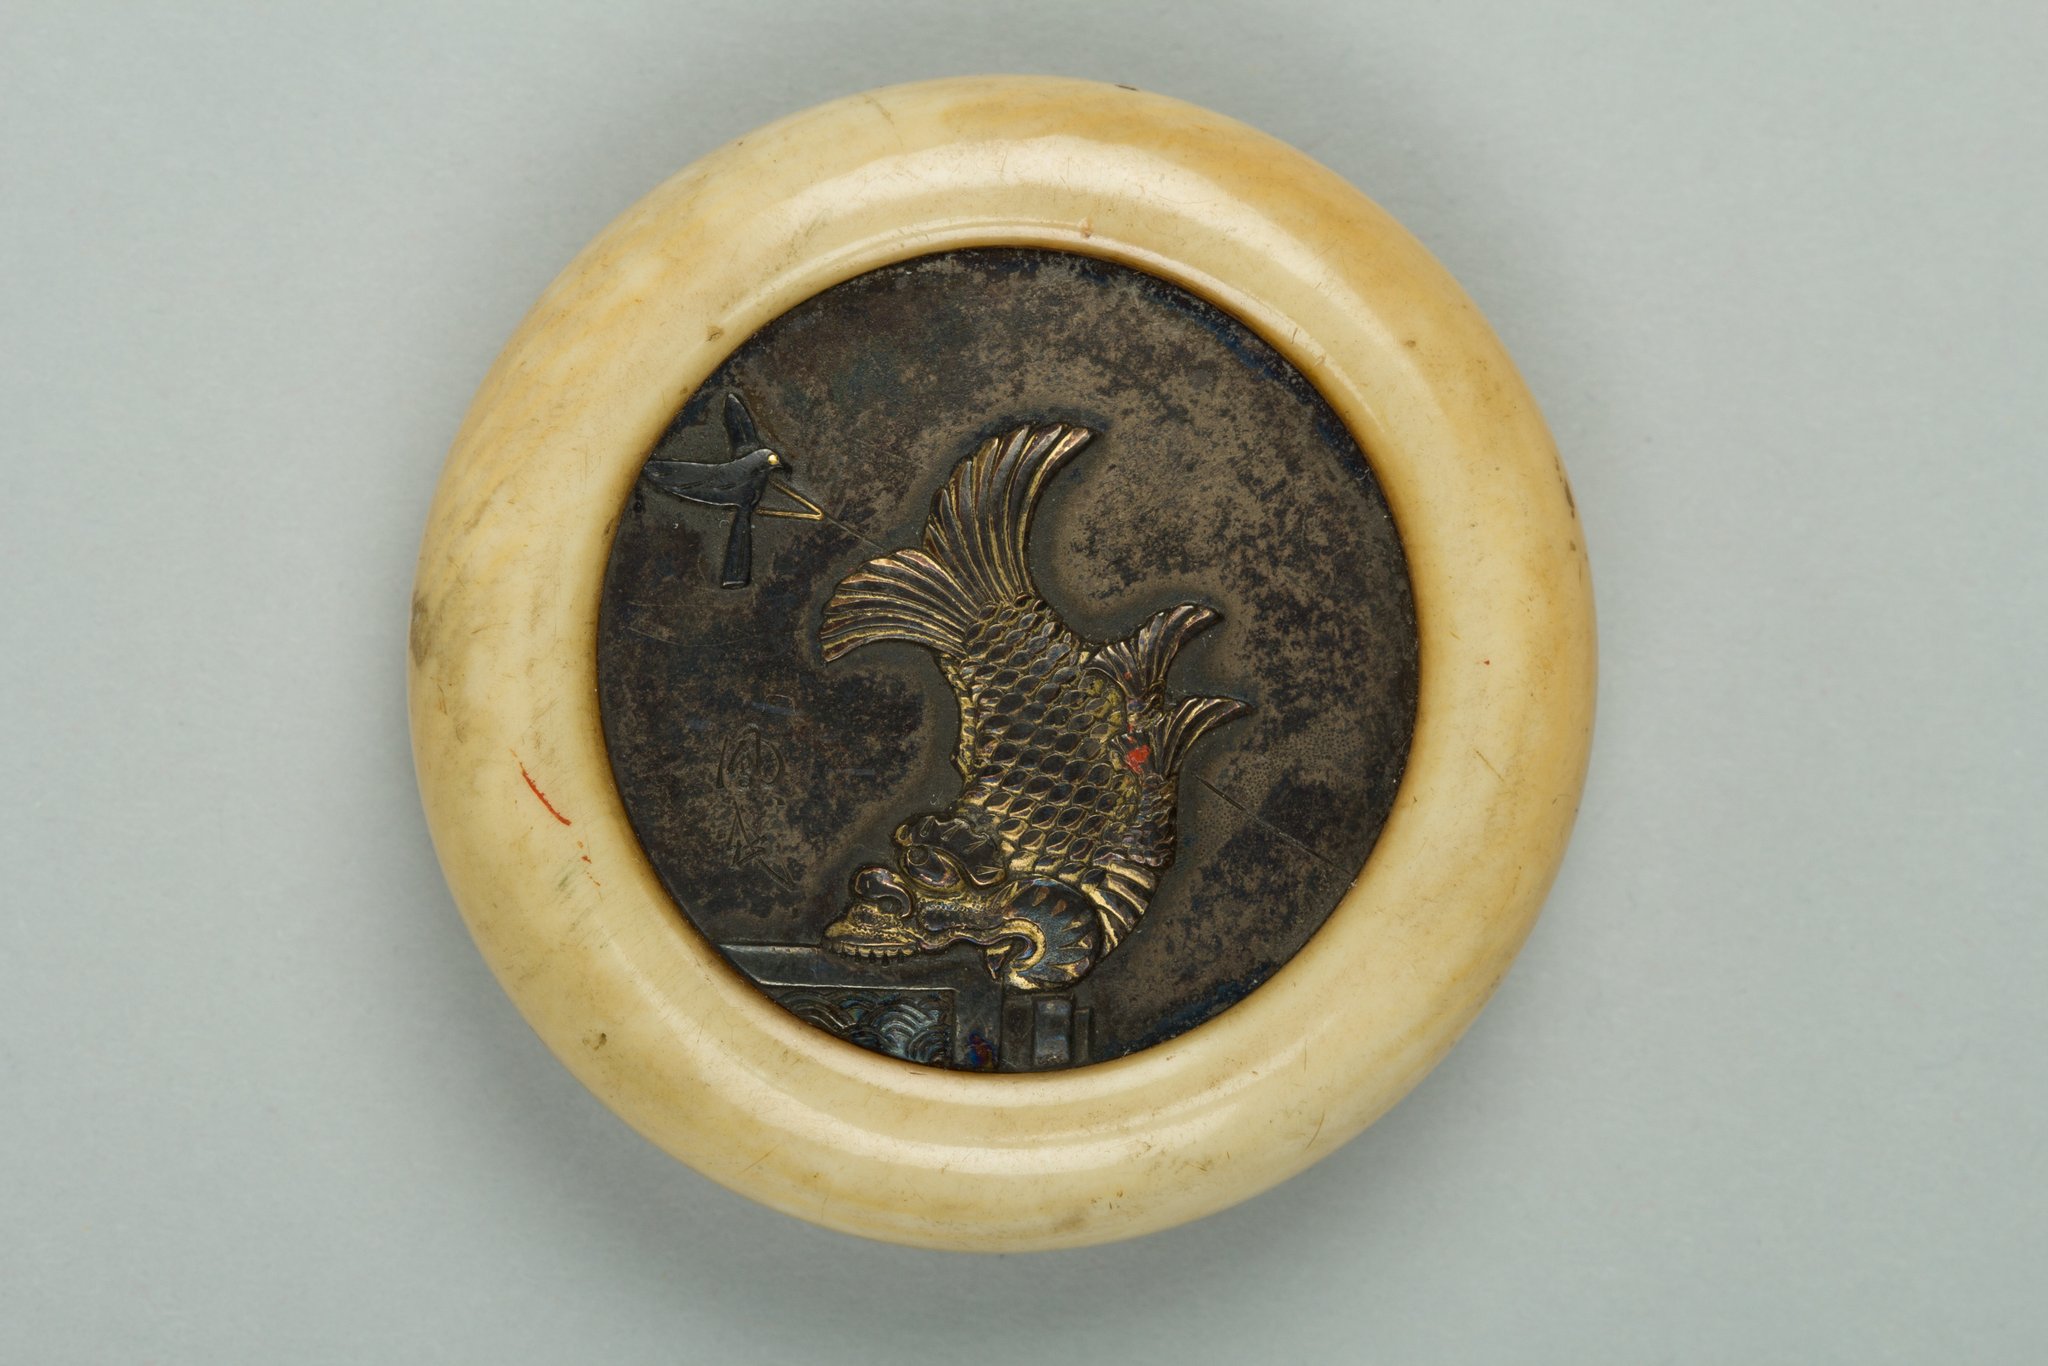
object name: netsuke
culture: japanese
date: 1801-1900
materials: ivory, metal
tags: birds